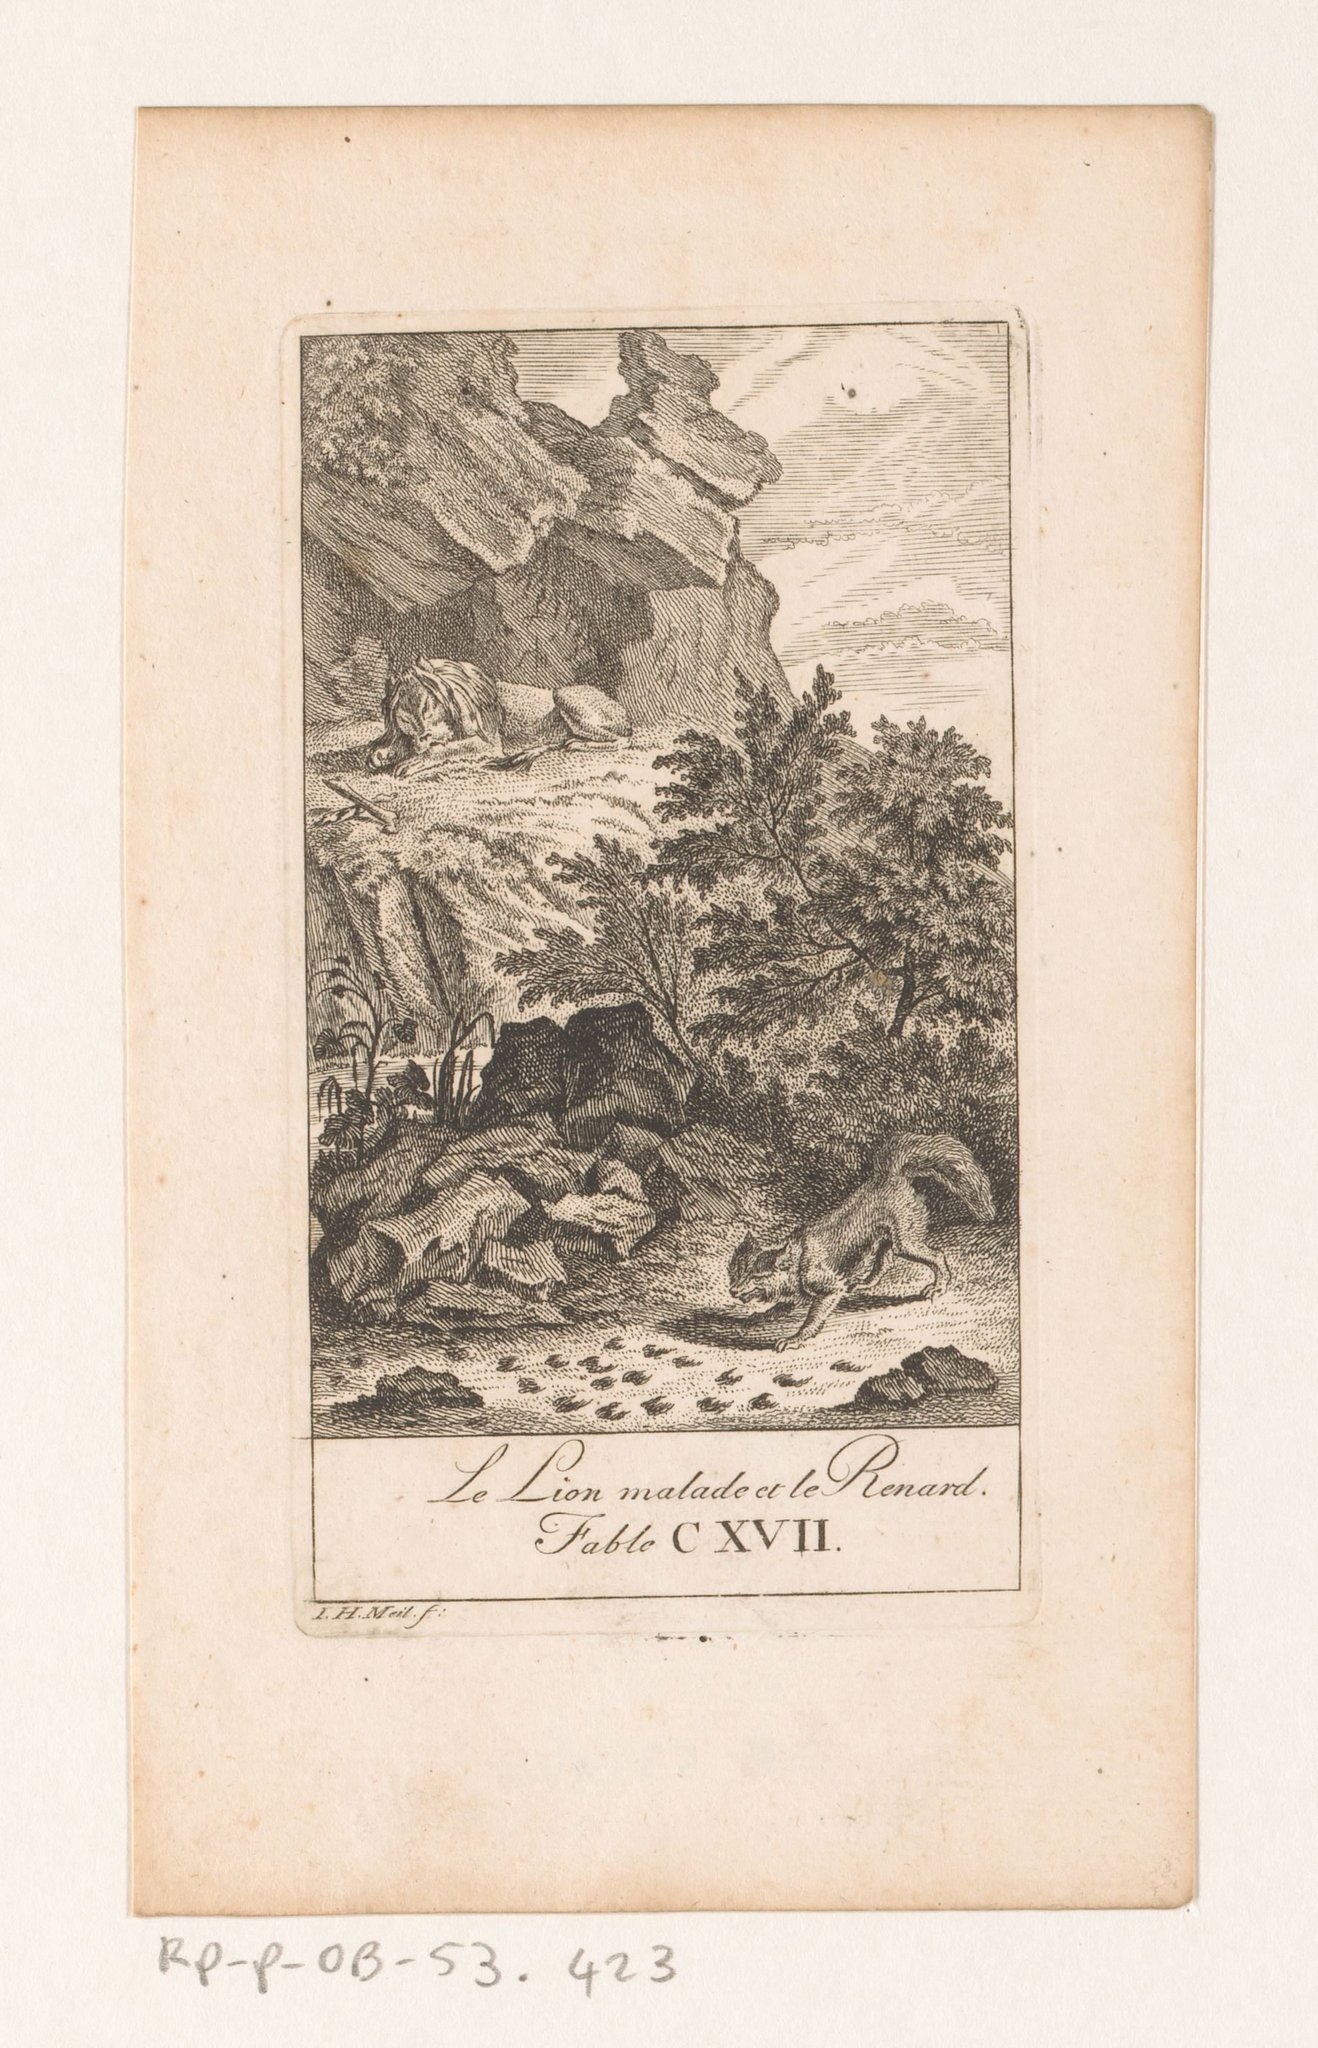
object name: book illustration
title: Fabel van de zieke leeuw en de vos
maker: johann heinrich meil (der ältere)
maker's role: print maker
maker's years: 1730-1820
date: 1758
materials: paper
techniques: etching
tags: fables of lafontaine : use 85(...), fable of reynard the fox, beasts of prey, predatory animals: lion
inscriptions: collector's mark: Lugt 2228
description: Illustratie uit: Fontaine, J. de la. Fables choisies, mises en vers. Dl. 2. Dresden & Leipzig: George Conrad Walther, 1758.